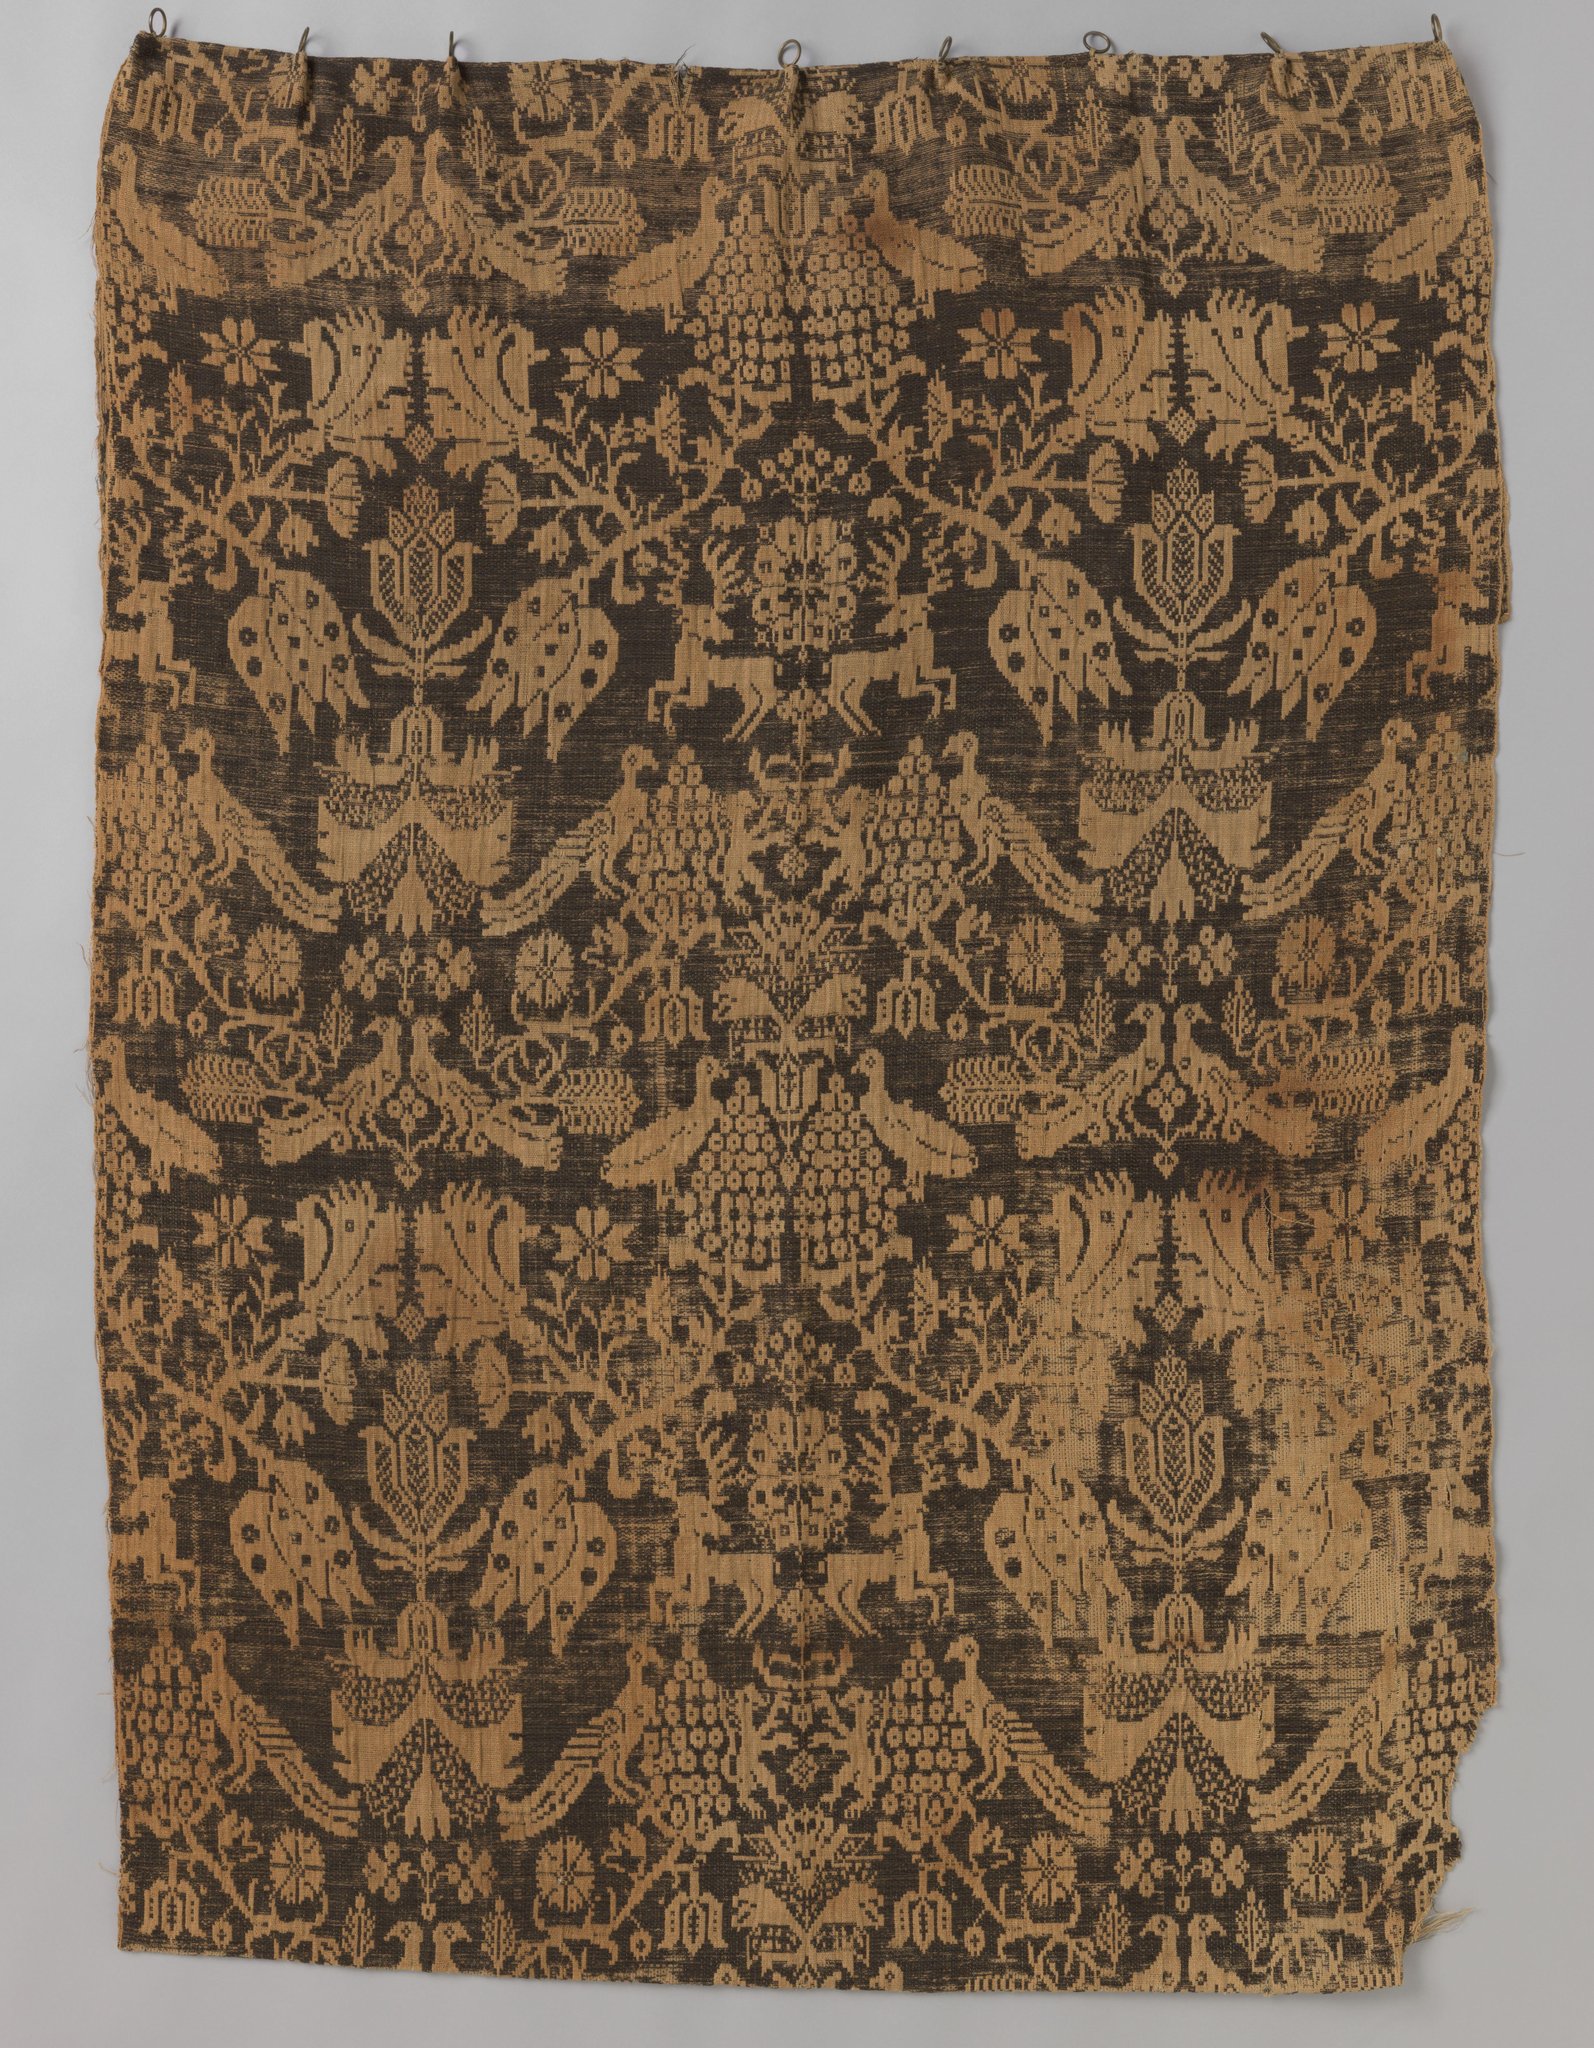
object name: bed curtain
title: Bedgordijn van "Beiderwand" weefsel in zwart en wit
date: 1650-1700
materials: linen, wool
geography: east frisia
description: Bedgordijn van z.g. "Beiderwand" weefsel. Het patroon in zwart en wit, is oneindig en symmetrisch op verticale assen, opgebouwd. De tekening bestaat uit vogeltjes, hertjes, palmetten, anjers, tulpen en druiventrossen. De texture is een dubbelweefsel, zodat aan de ene zijde het patroon wit op zwart is aan de andere zijde zwart op wit. Het gordijn is van wol en linnen.